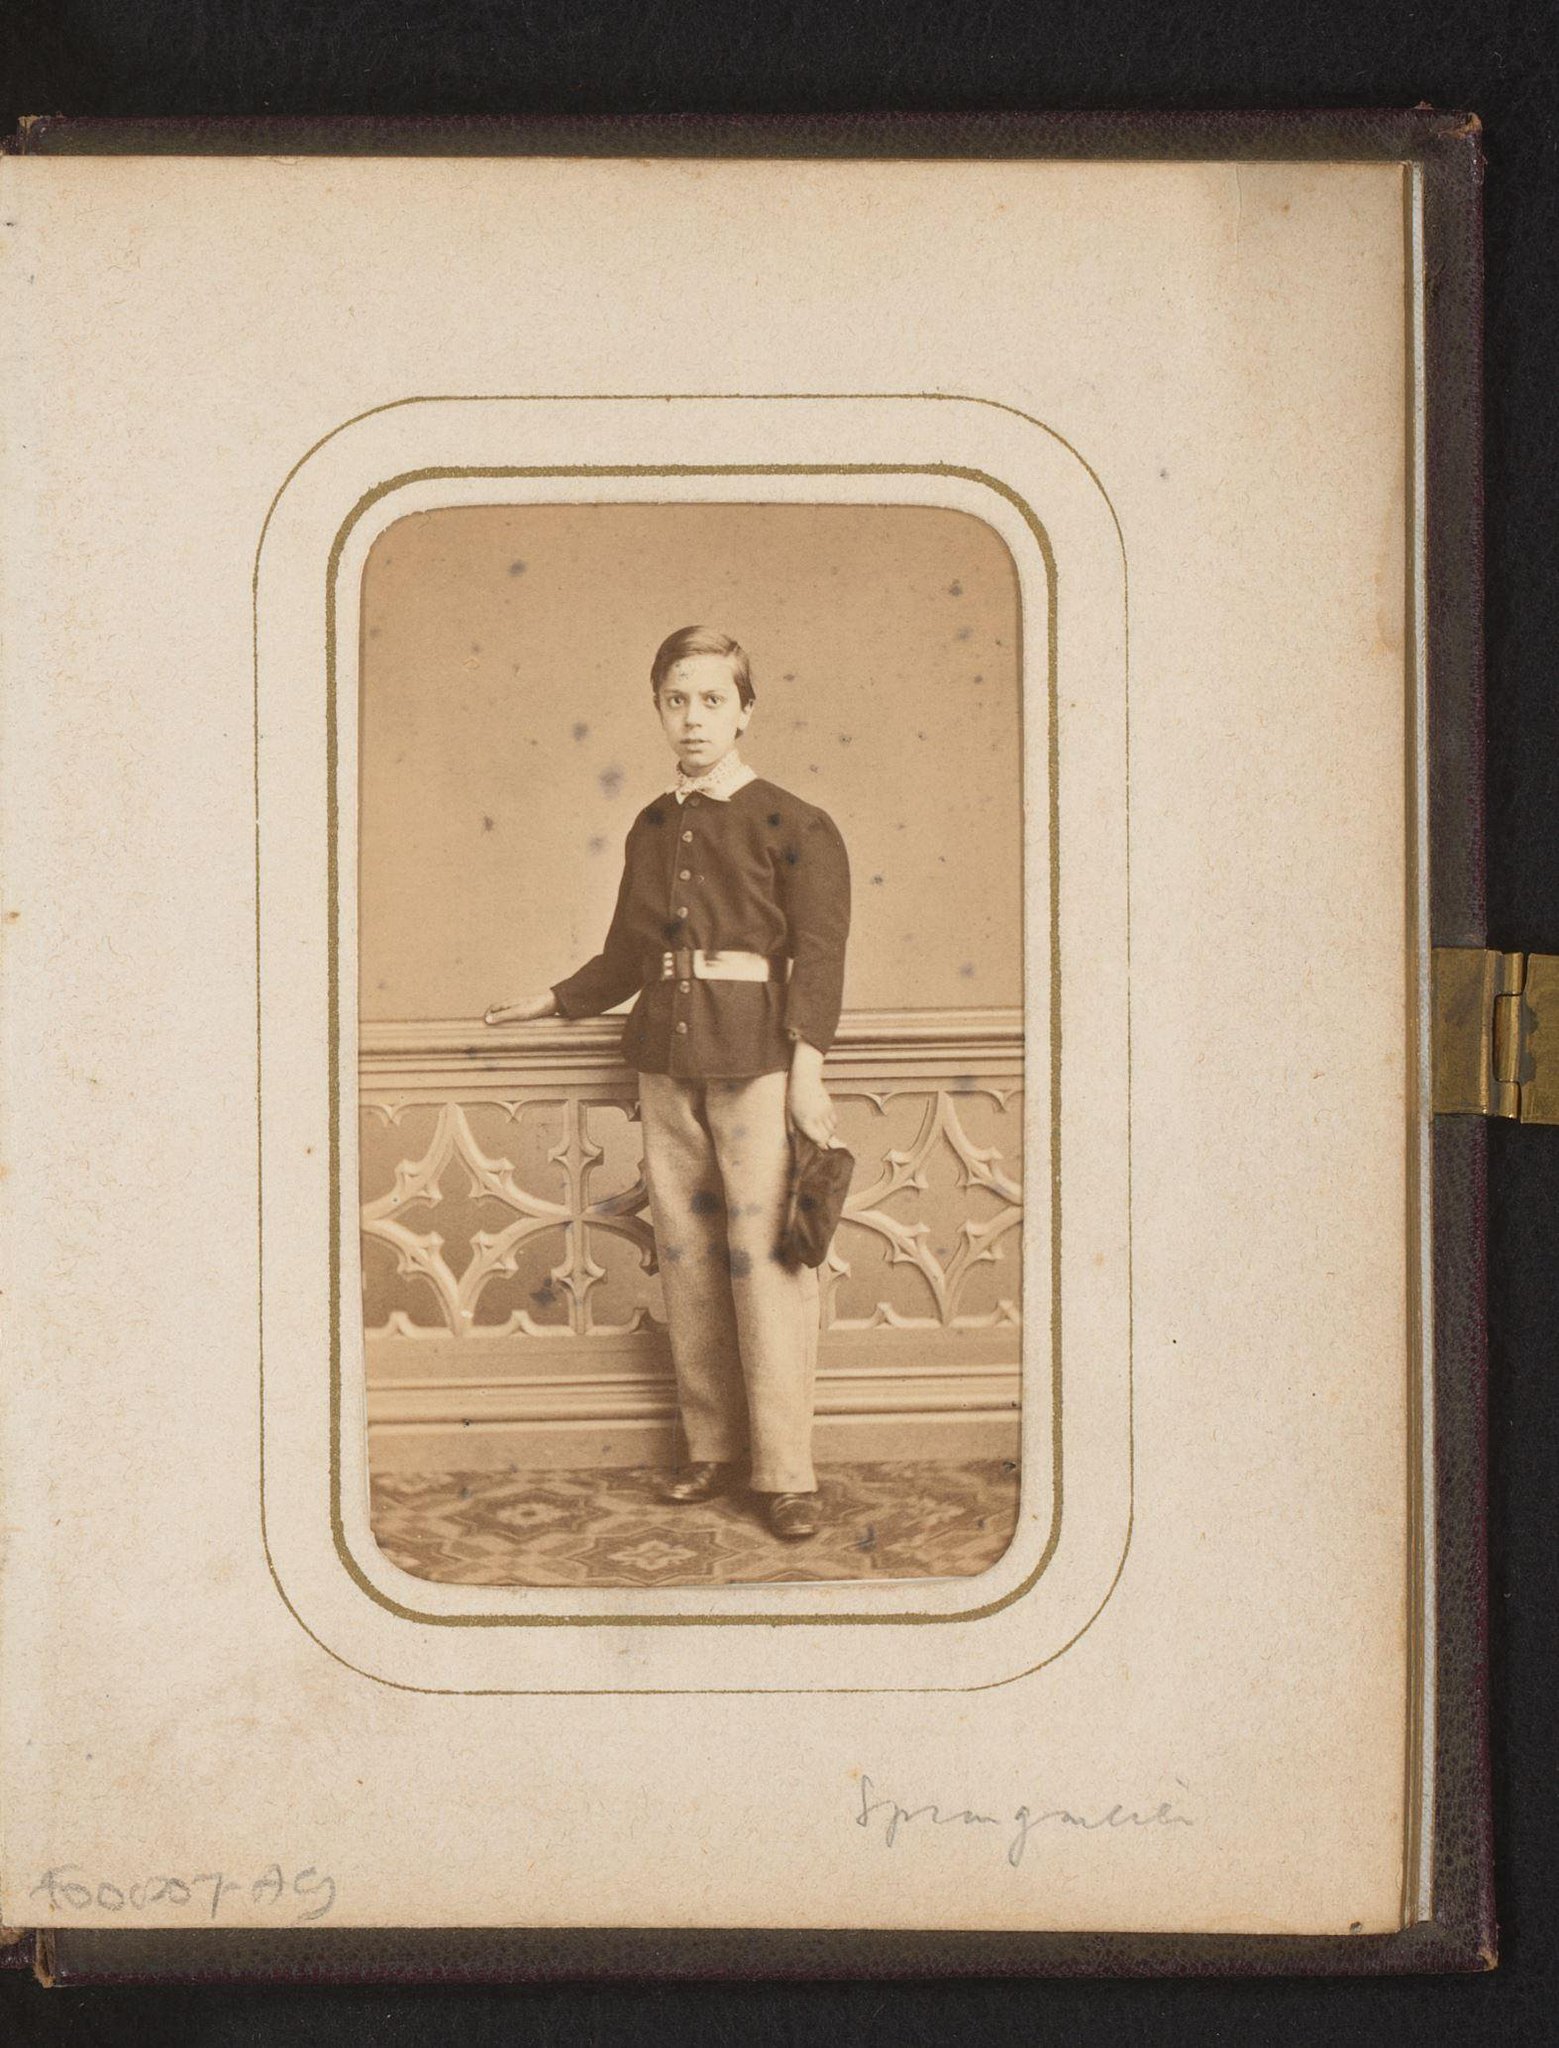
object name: album leaf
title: Portret van een jongen met pet in de hand, staand bij een balustrade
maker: f. springmeier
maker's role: fotograaf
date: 1860-1900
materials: cardboard, photographic support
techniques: albumen print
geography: elberfeld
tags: boy (child between toddler and youth), historical persons, balustrade, head-gear: cap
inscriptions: inscription: ‘F. Springmeier/ PHOTOGRAPH/ Elberfeld/ Herzogstrasse, No 4.’, annotation: ‘Springmeier’